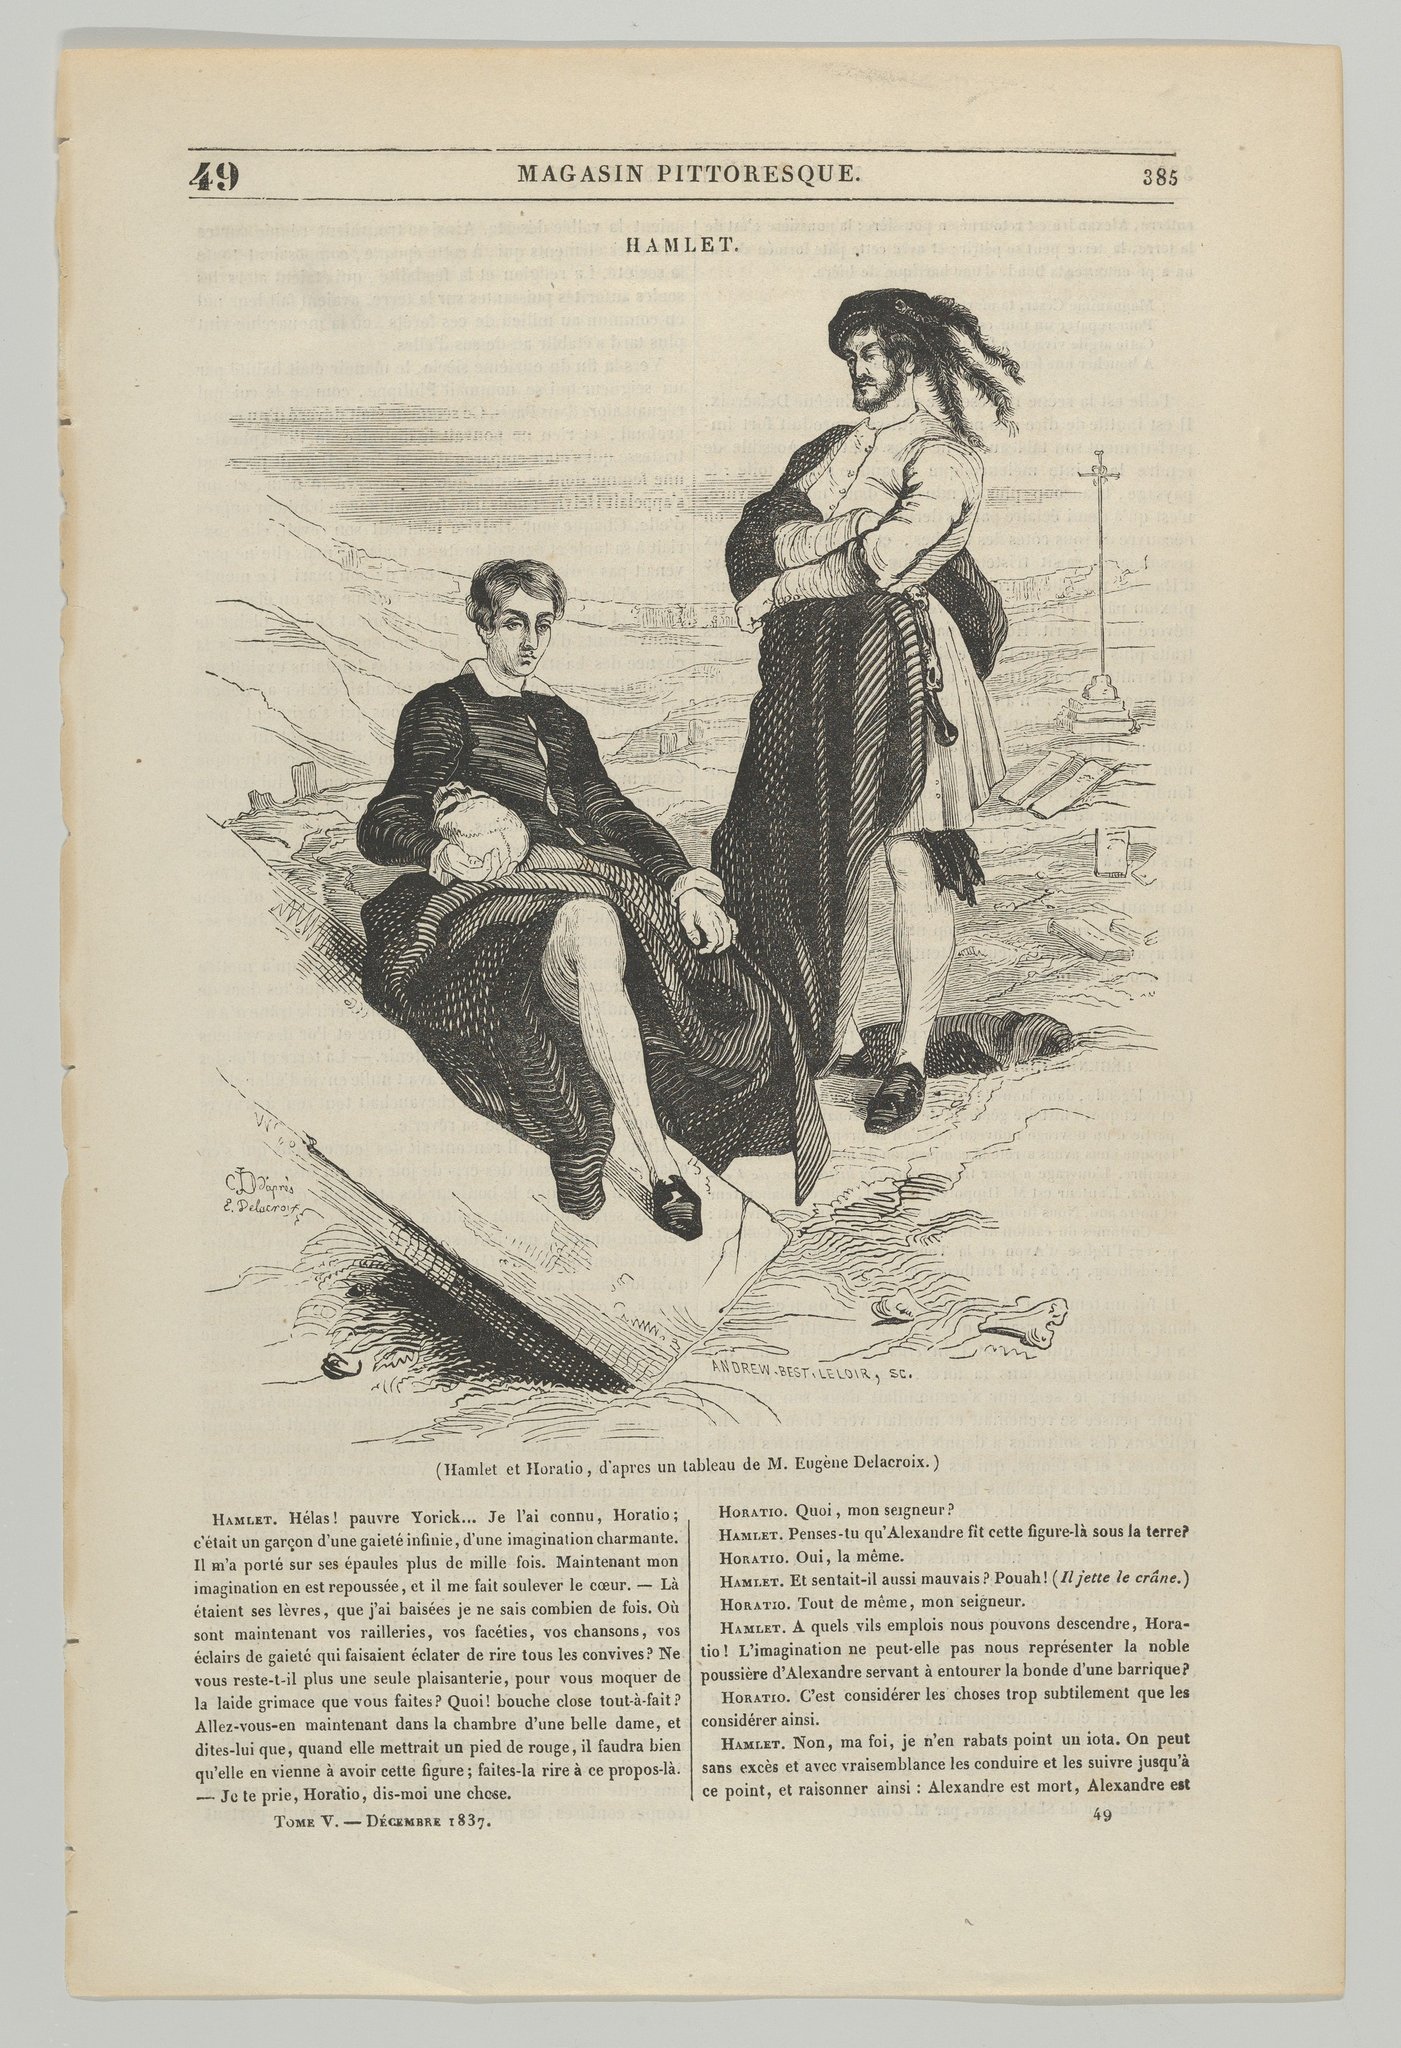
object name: print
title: Hamlet and Horatio, from "Le Magasin Pittoresque"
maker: andrew best leloir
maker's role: engraver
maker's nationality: french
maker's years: 1832-1850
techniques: engraving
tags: shakespeare,men,hamlet